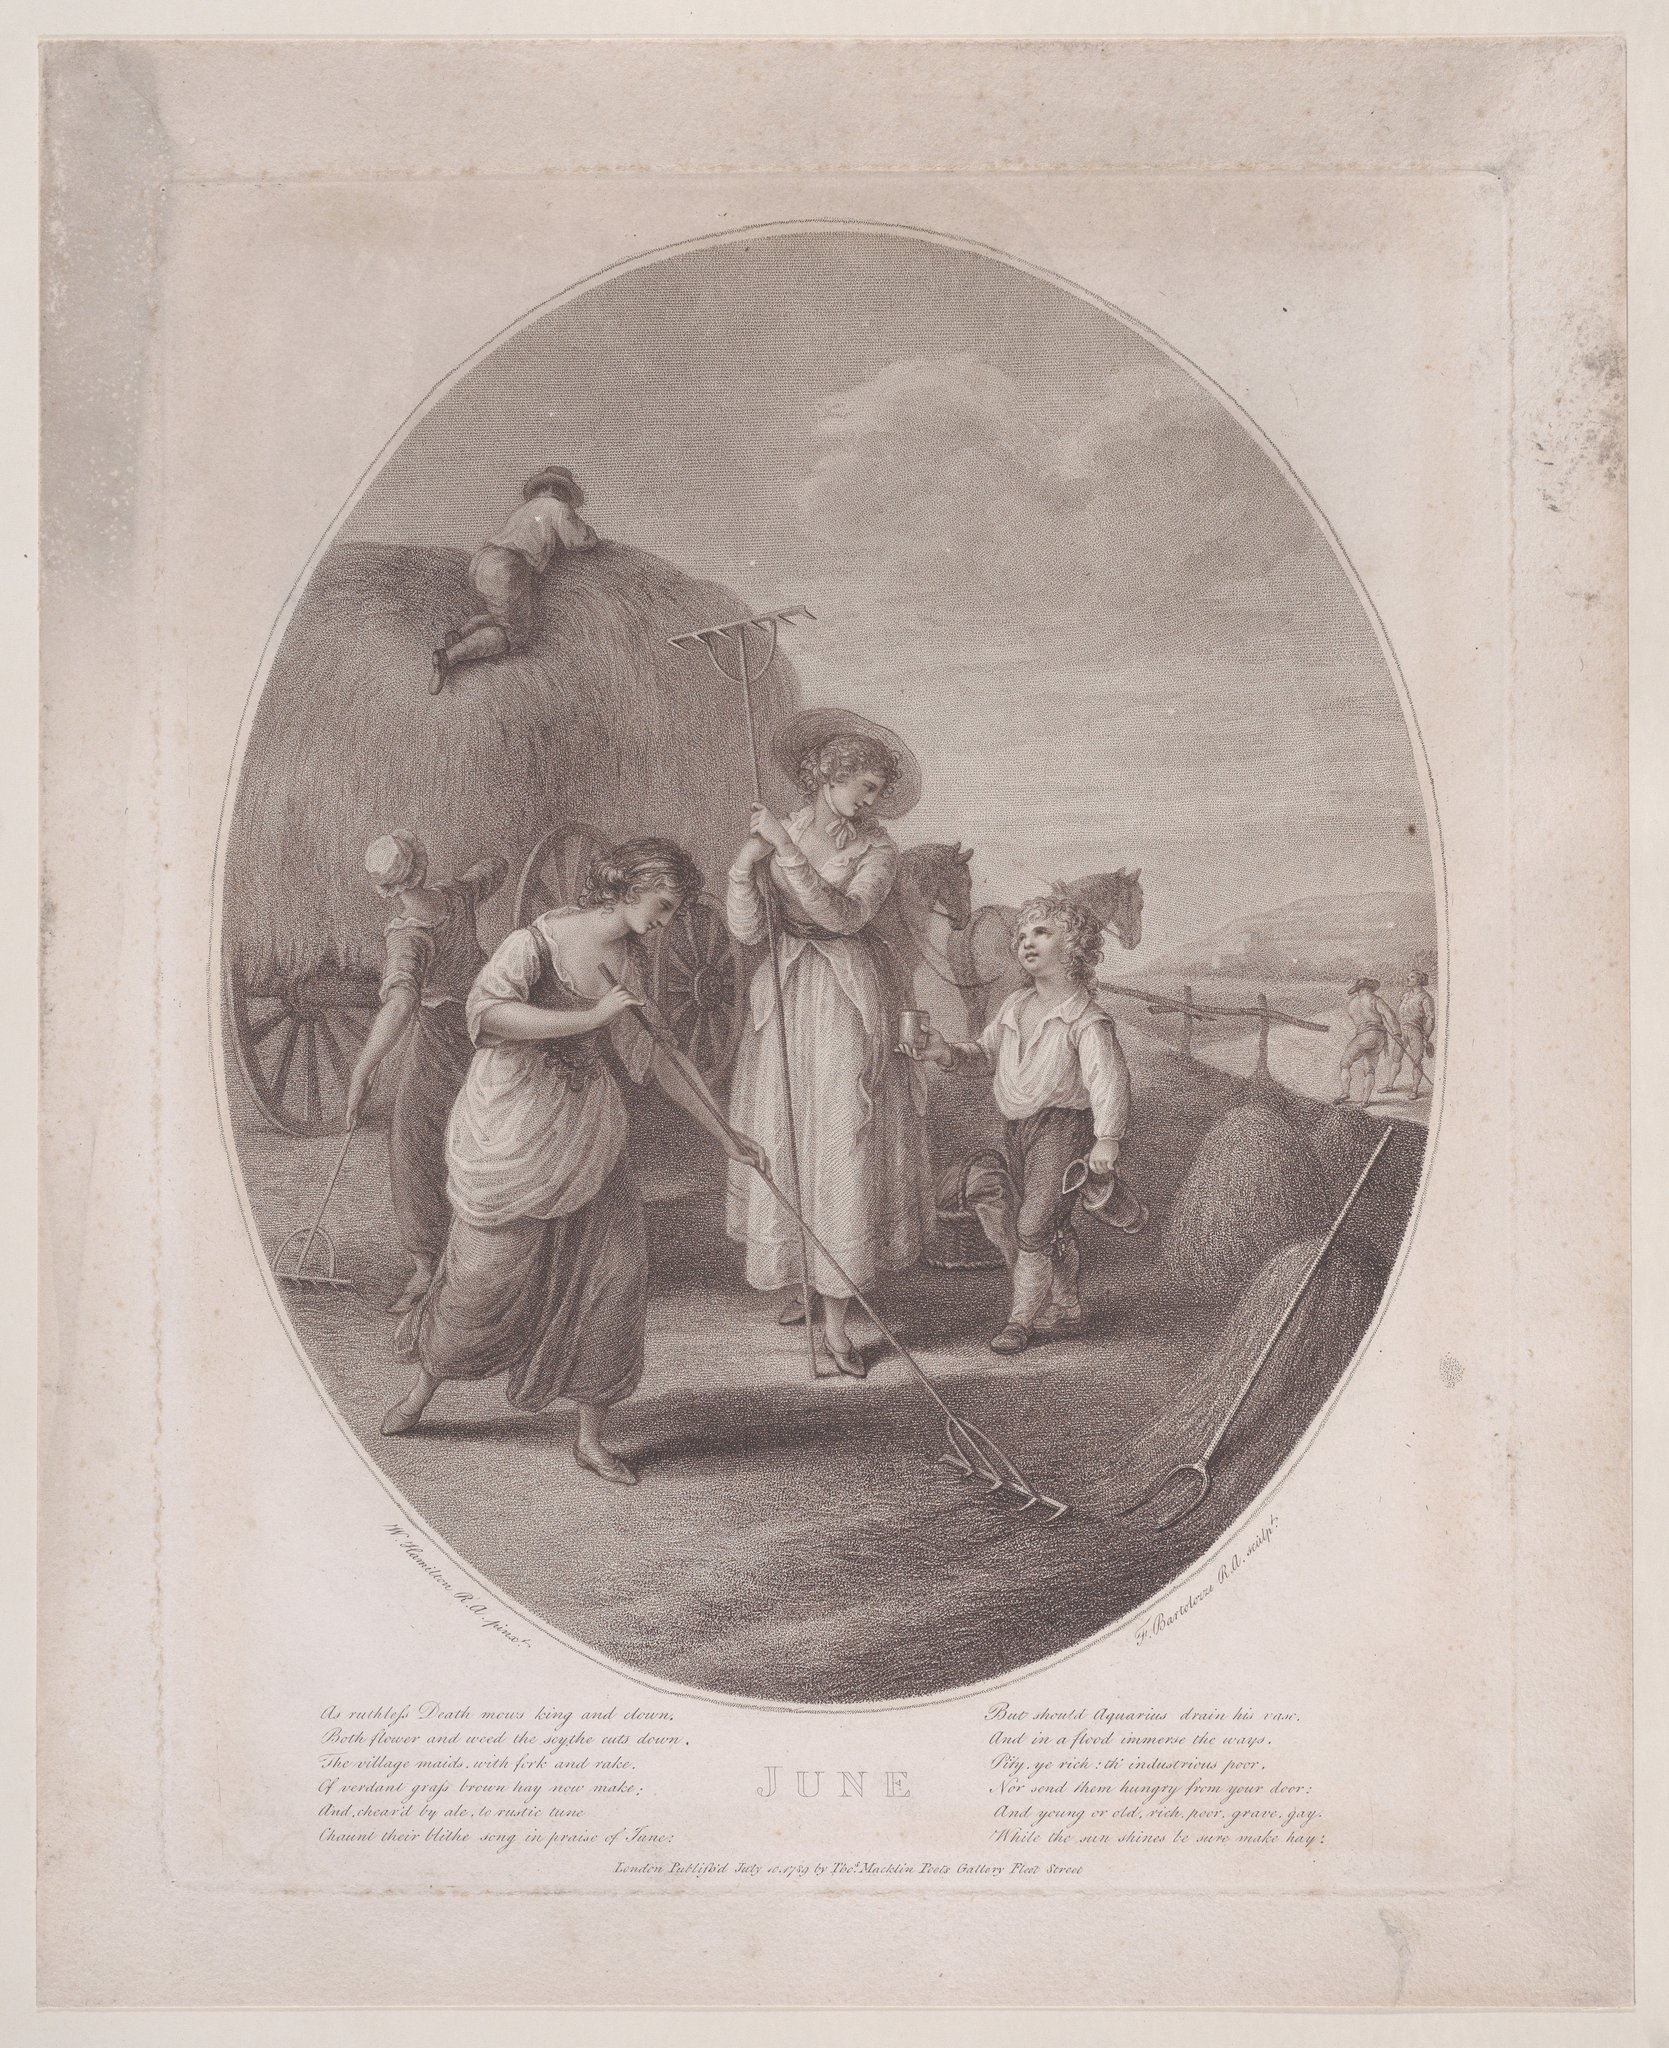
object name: print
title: June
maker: francesco bartolozzi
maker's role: artist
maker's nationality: italian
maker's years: 1728-1815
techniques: engraving, etching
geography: england